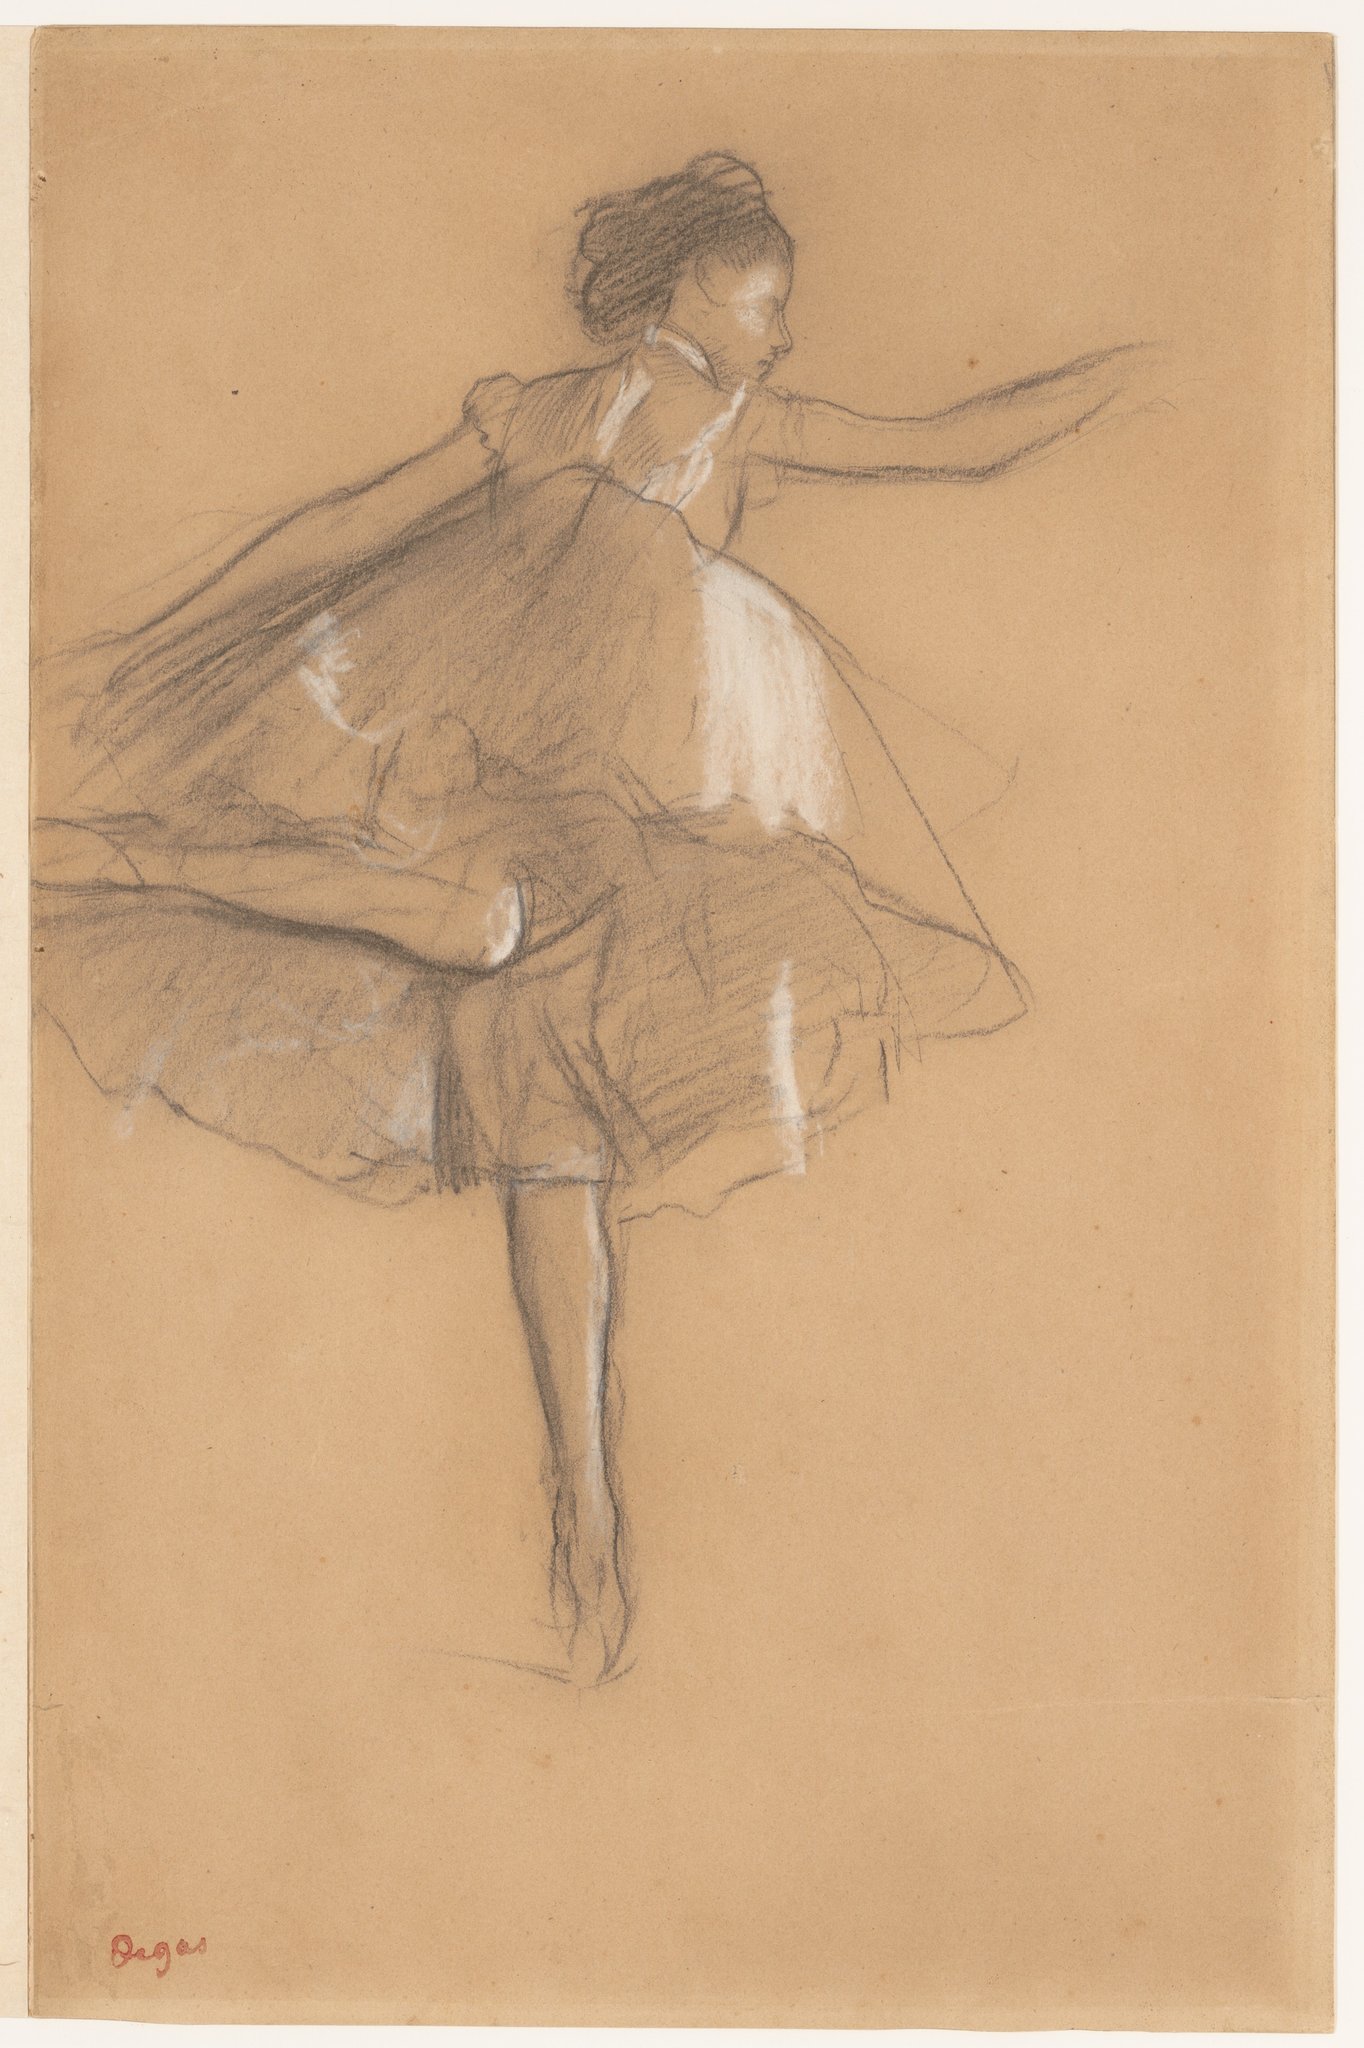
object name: drawing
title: Dancer on pointe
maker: edgar degas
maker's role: artist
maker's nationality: french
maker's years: 1834-1917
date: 1878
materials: charcoal, paper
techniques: heightening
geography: france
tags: women,dancing,ballet